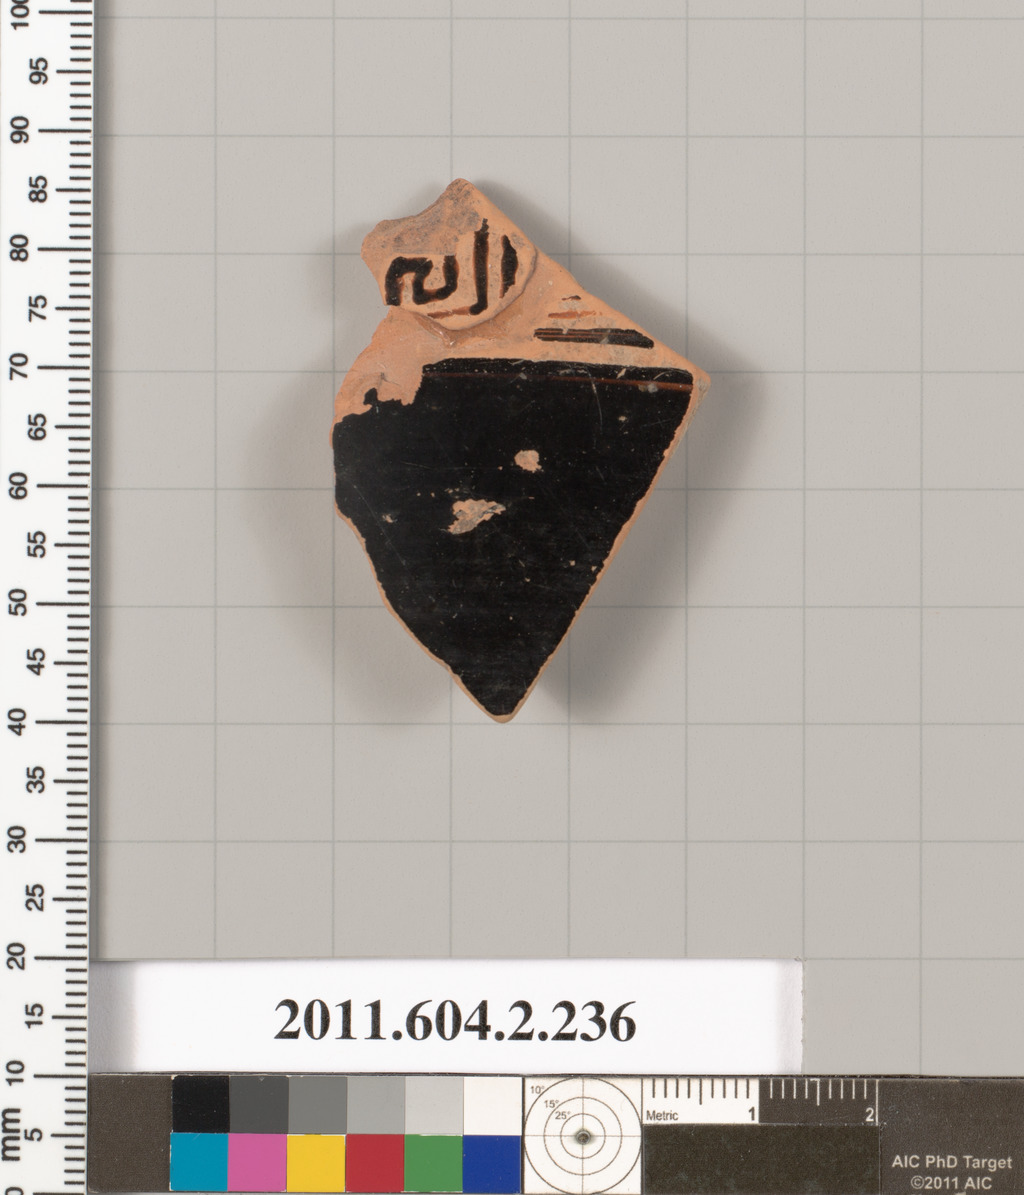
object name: stamnos fragment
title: Terracotta fragment of a stamnos (jar)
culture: greek, attic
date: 460-440 BCE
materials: terracotta